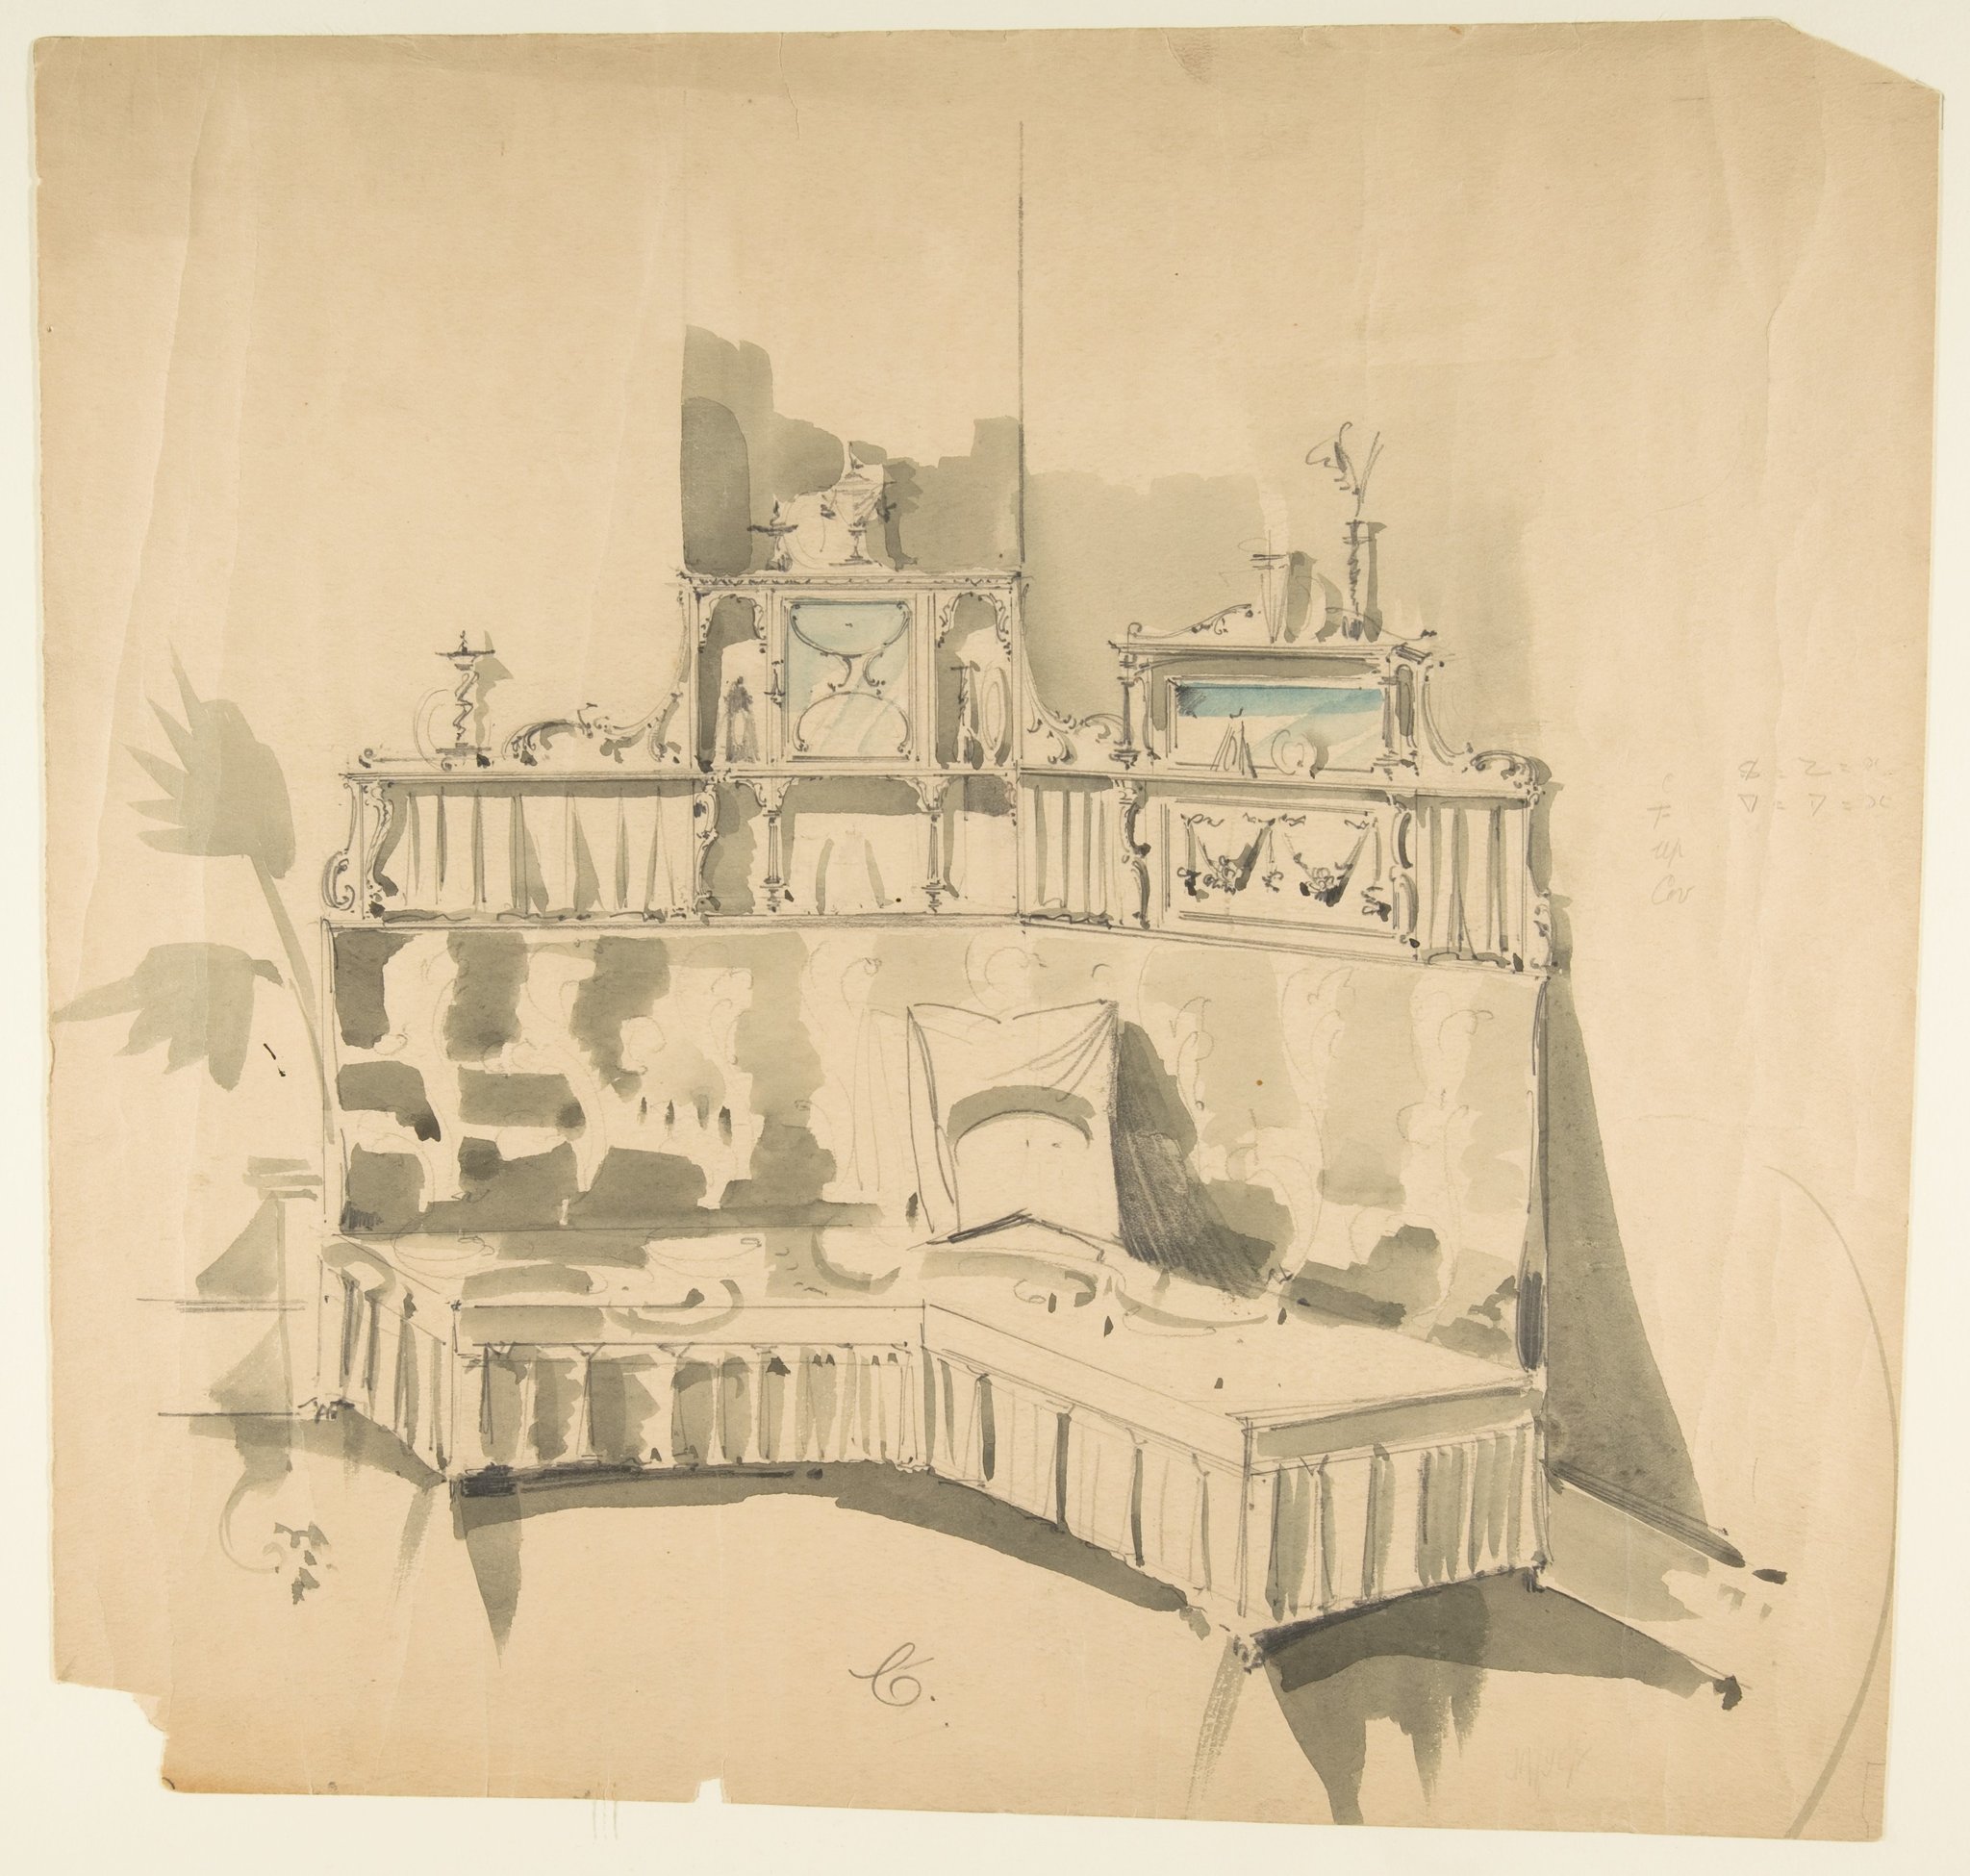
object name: drawing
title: Furniture Designs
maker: anonymous, french, 19th century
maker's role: artist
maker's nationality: french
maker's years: 1800-1900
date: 1801-1900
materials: graphite, watercolor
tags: furniture